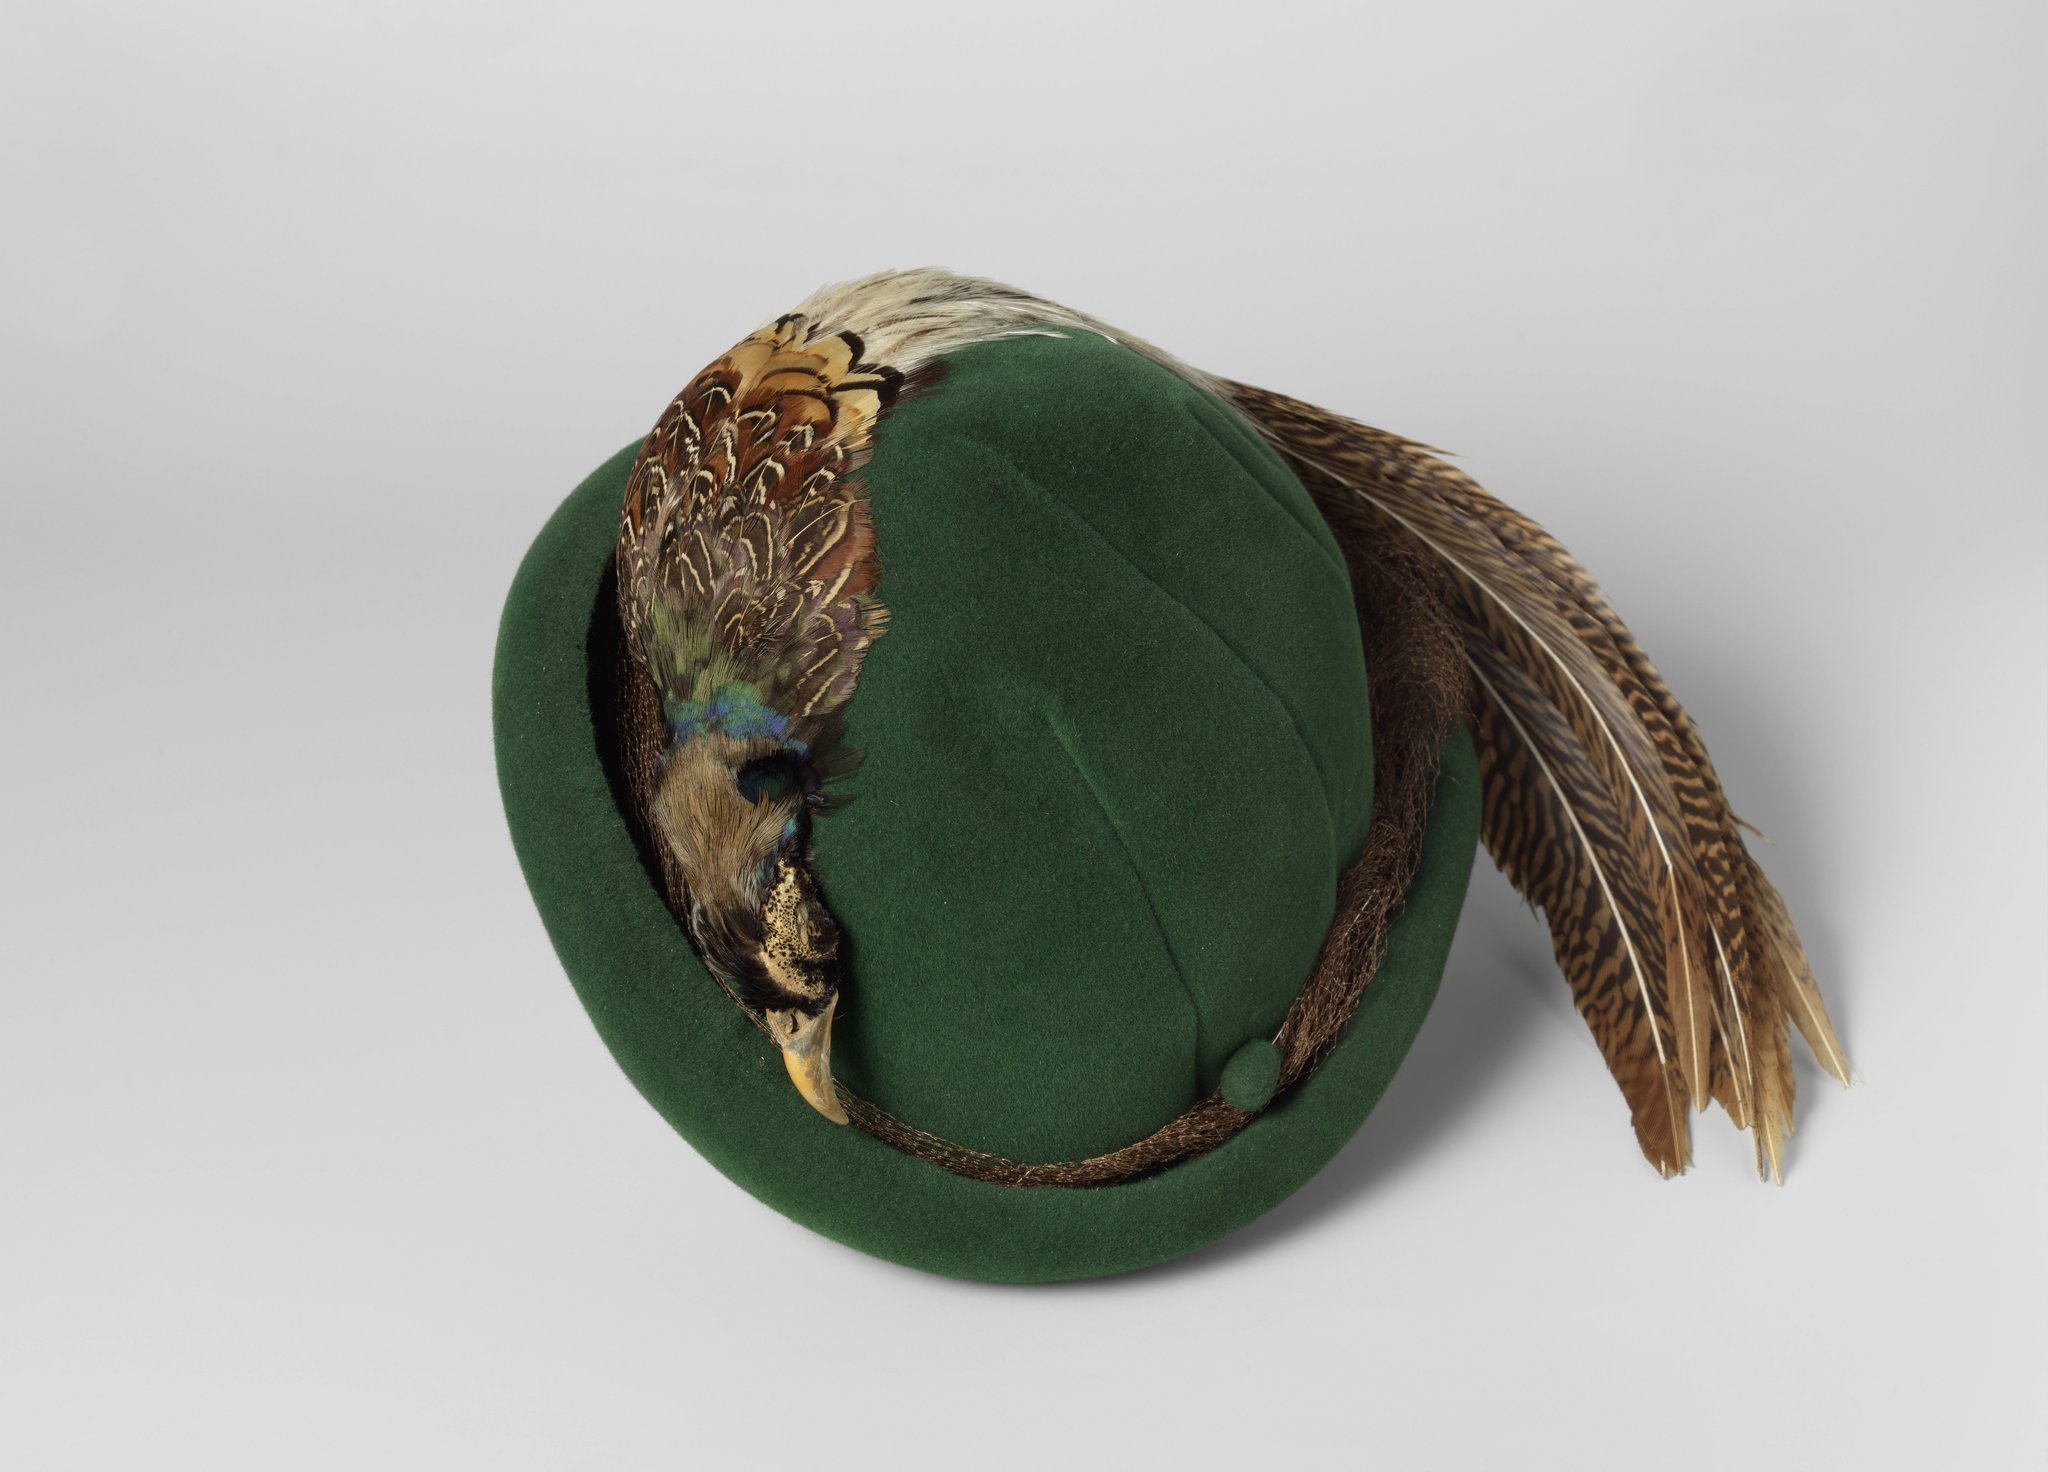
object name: clothing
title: Hoedenspeld behorend bij cloche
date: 1945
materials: metal, textile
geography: paris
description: Cloche van groen vilt met fazant en bruine voile, voorzien van bijpassende hoedenspeld (Legrouse soeurs).